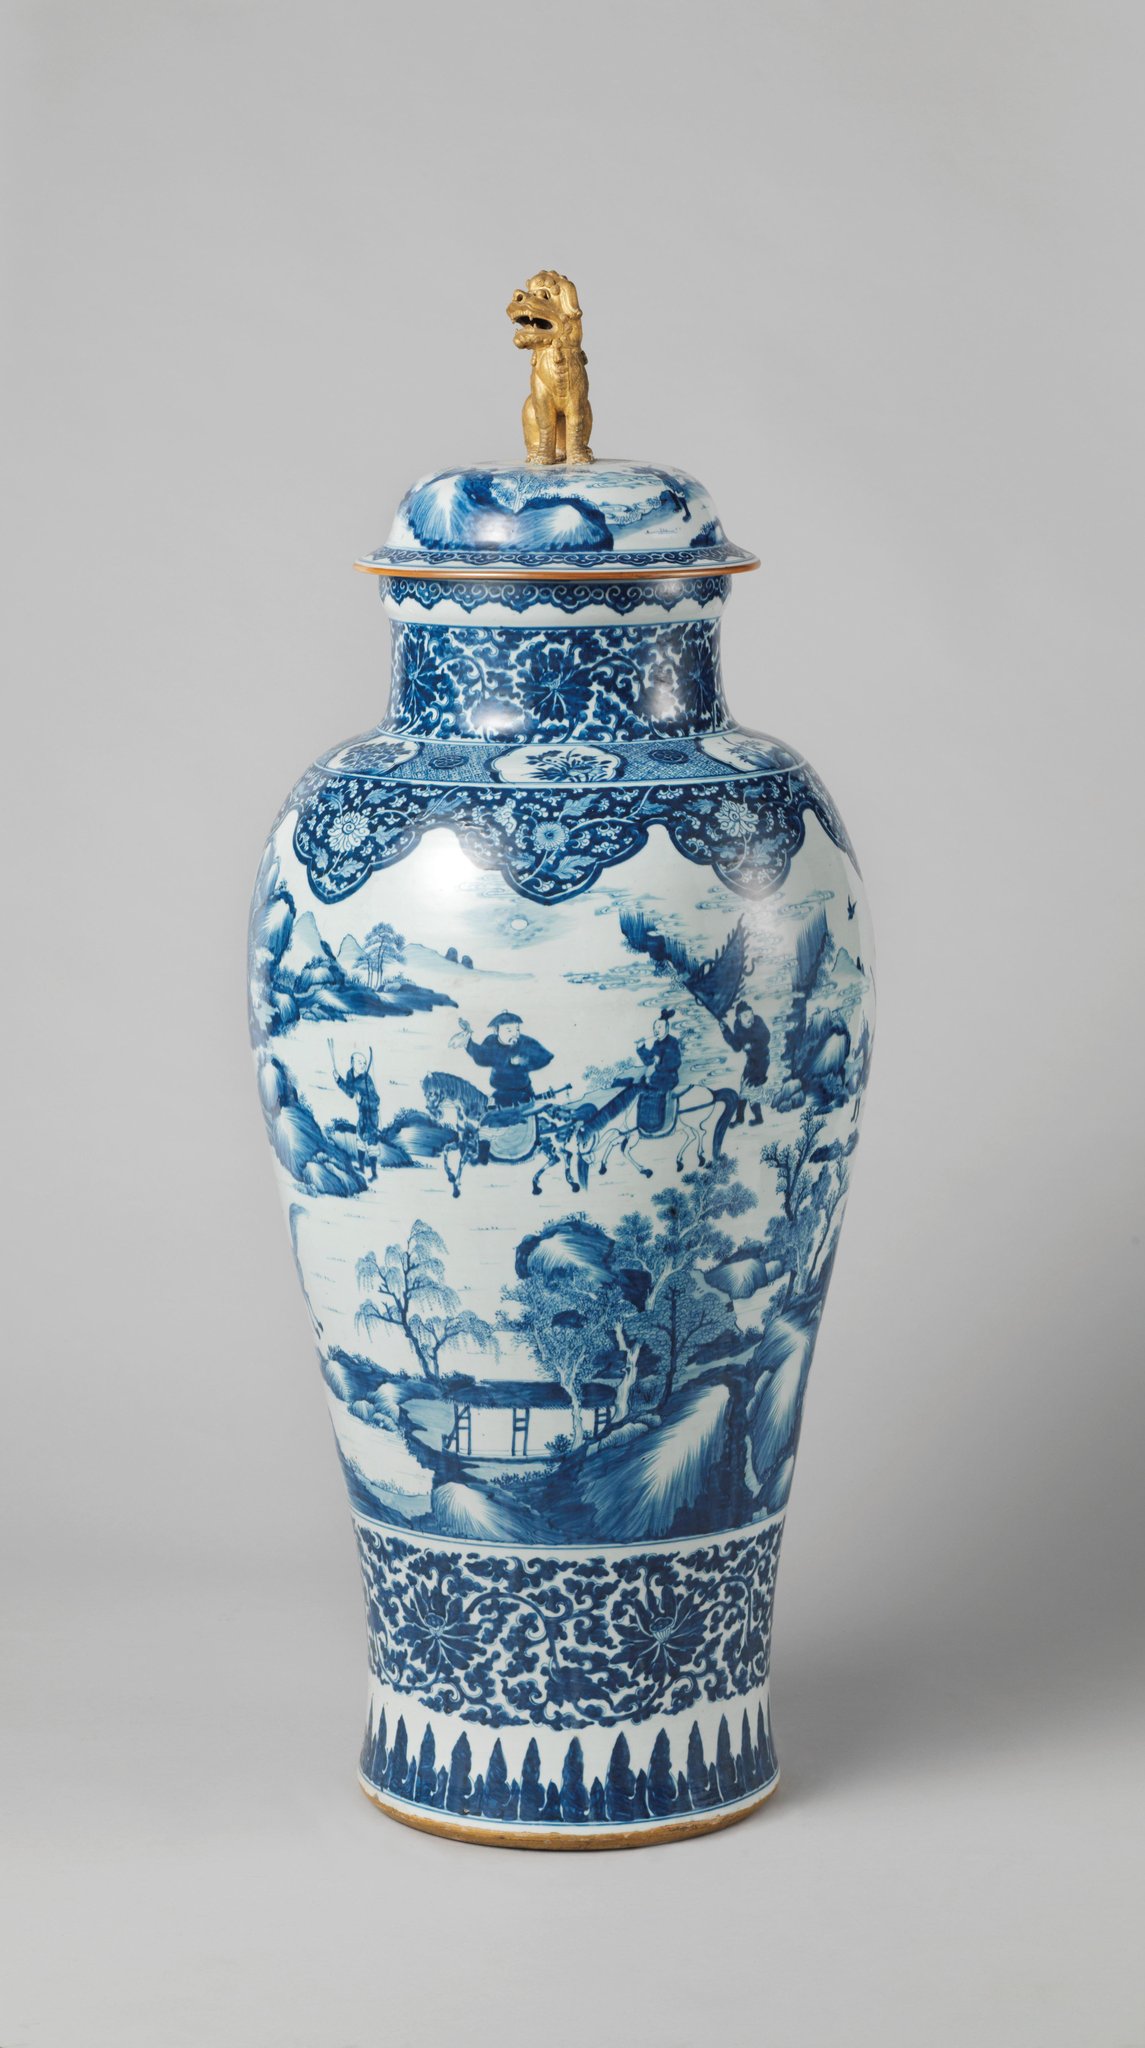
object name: dekselvaas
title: Baluster vase with a hunting scene and borders with floral scrolls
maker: Anonymous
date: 1700-1724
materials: cobalt, glaze, gold, paint, porcelain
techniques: firing, forming, gilding, turning, vitrification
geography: china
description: Deksel van porselein, beschilderd in onderglazuur blauw en op het glazuur goud. Op de wand een jachtscène met jagers te paard en te voet met wapens en honden in een landschap met bomen, bergen en rotsen. Hieronder een band met lotusranken. Dekselknop in de vorm van een shishi. Blauw-wit.